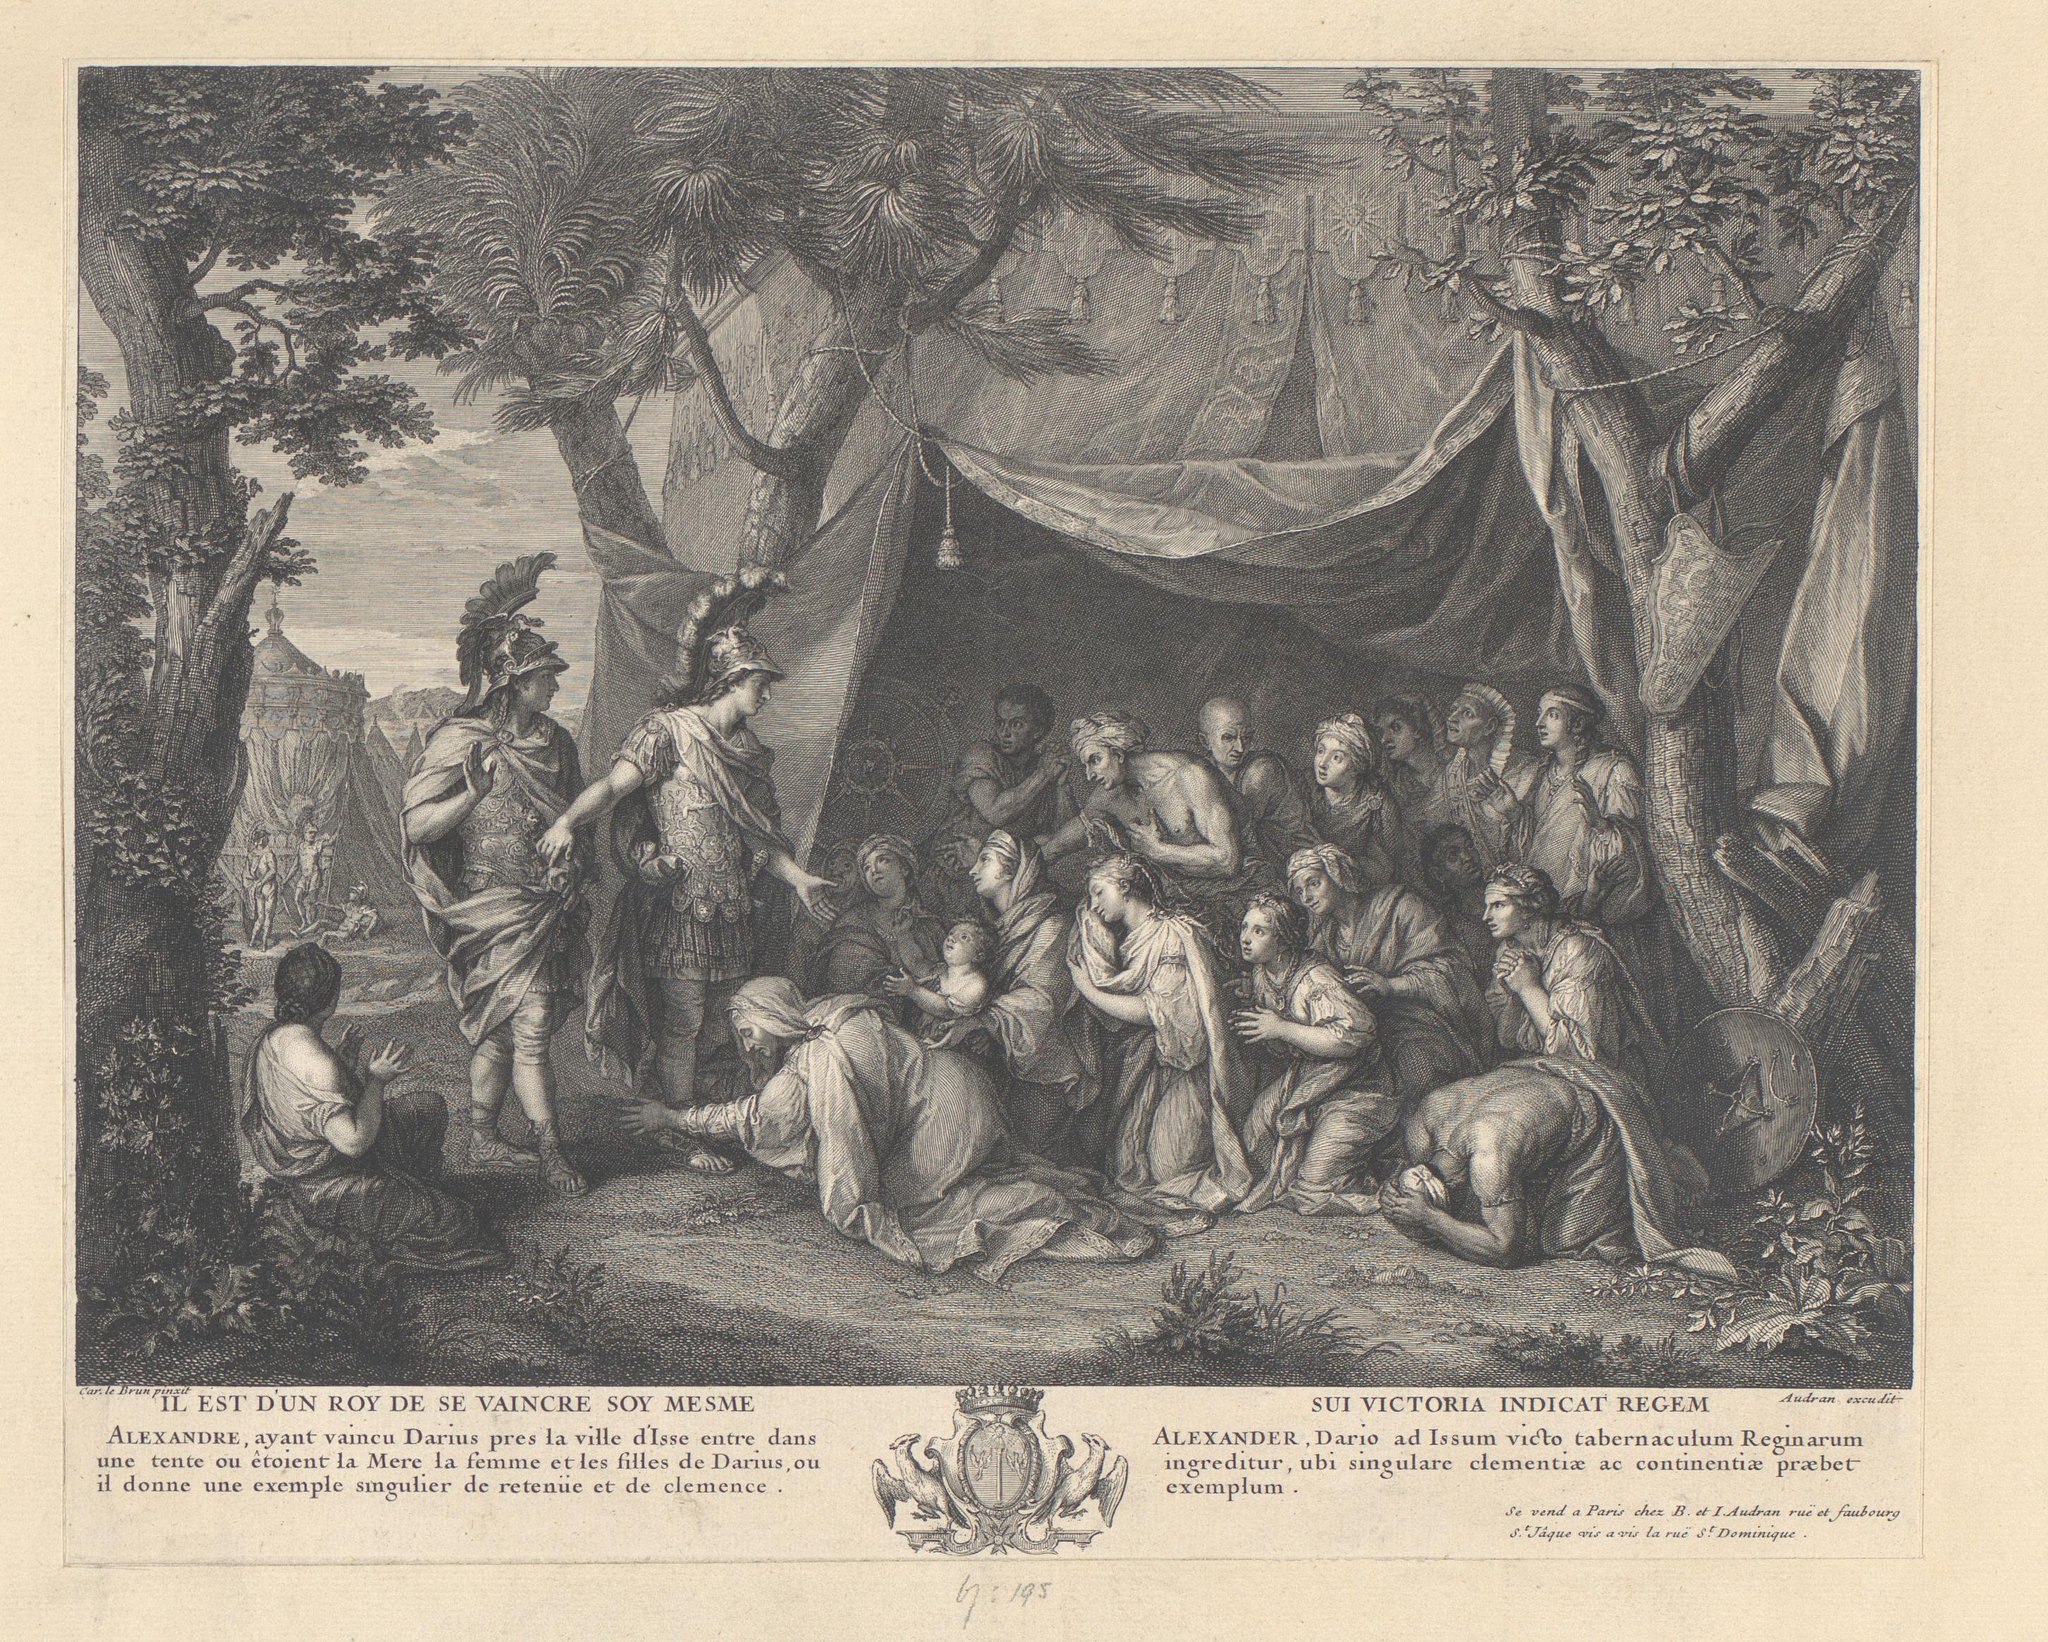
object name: album leaf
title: L'ouvrage de Charles le Brun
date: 1677-1756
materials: paper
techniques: engraving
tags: darius' family kneels before alexander, who requests sisigambis, darius' mother, to rise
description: Deze prent maakt deel uit van een album.